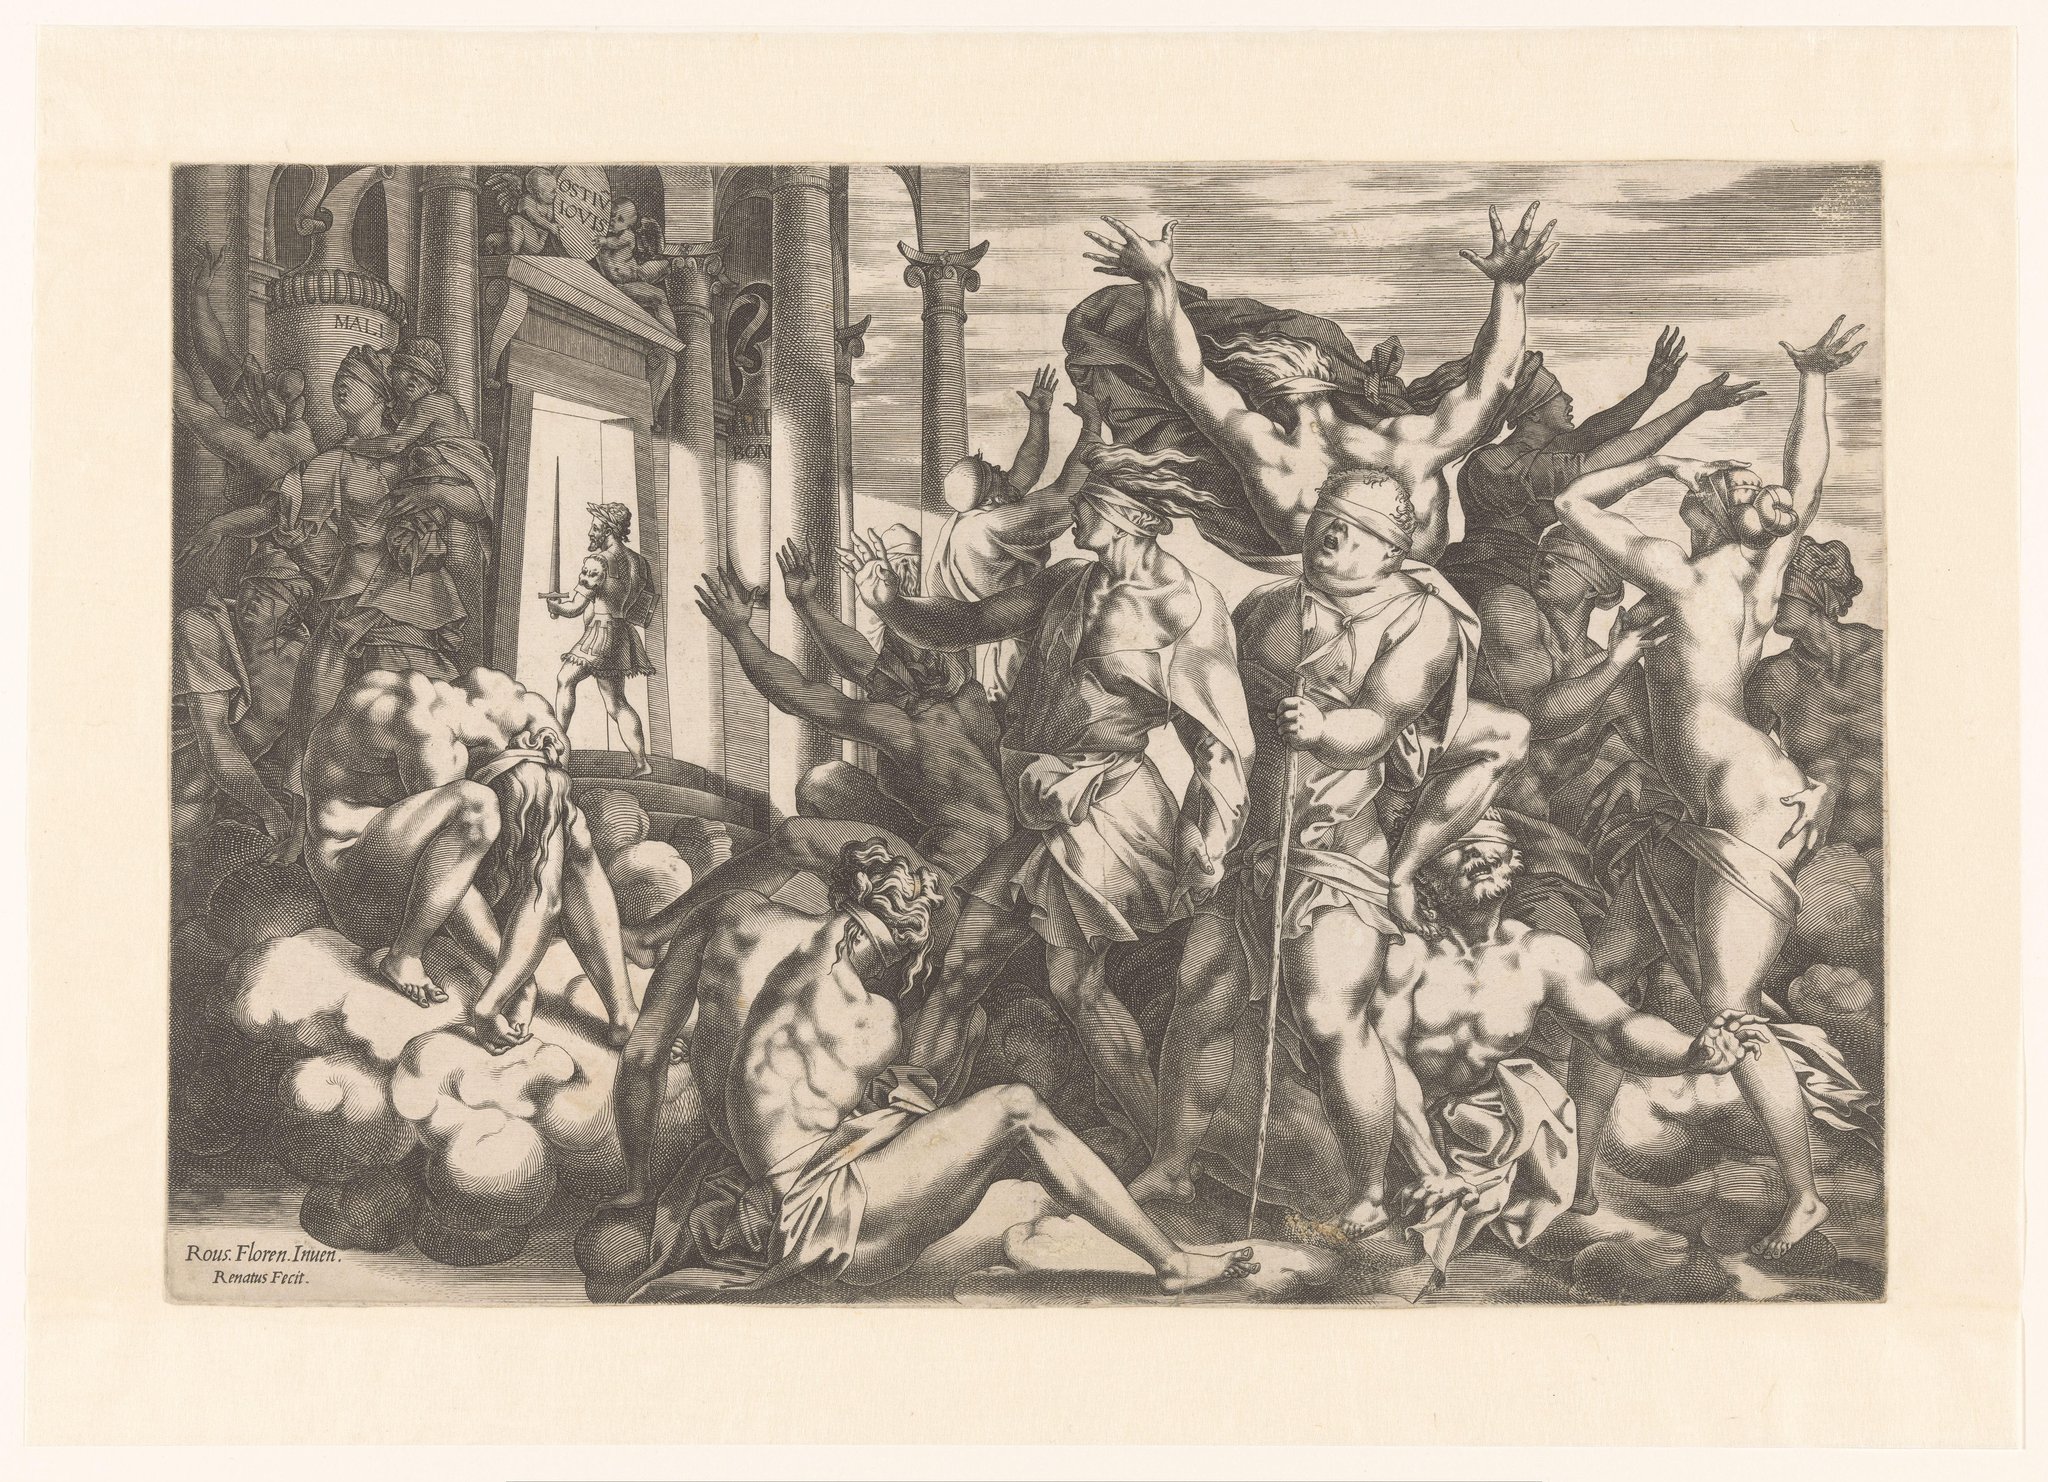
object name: print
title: Overwinning op de onwetendheid: Koning Frans I van Valois-Angoulême opent de tempel van Jupiter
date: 1535-1598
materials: paper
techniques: engraving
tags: frans i van valois-angoulême (koning van frankrijk), victory, ignorance; 'ignoranza', 'ignoranza di tutte le cose', 'ignoranza in un ricco senza lettere' (ripa), blindfold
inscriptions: inscription: ‘f 9(?) guldens ende 9(?) stuijvers, ofte drie ducatens;’, collector's mark: Lugt 240, inscription: ‘MALI’, inscription: ‘OSTIV// IOVIS’, inscription: ‘BONI’, signature: ‘Renatus Fecit.’, inscription: ‘Rous. Floren. Inuen.’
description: De schildering door Rosso Fiorentino bevindt zich in het Kasteel van Fontainebleau.